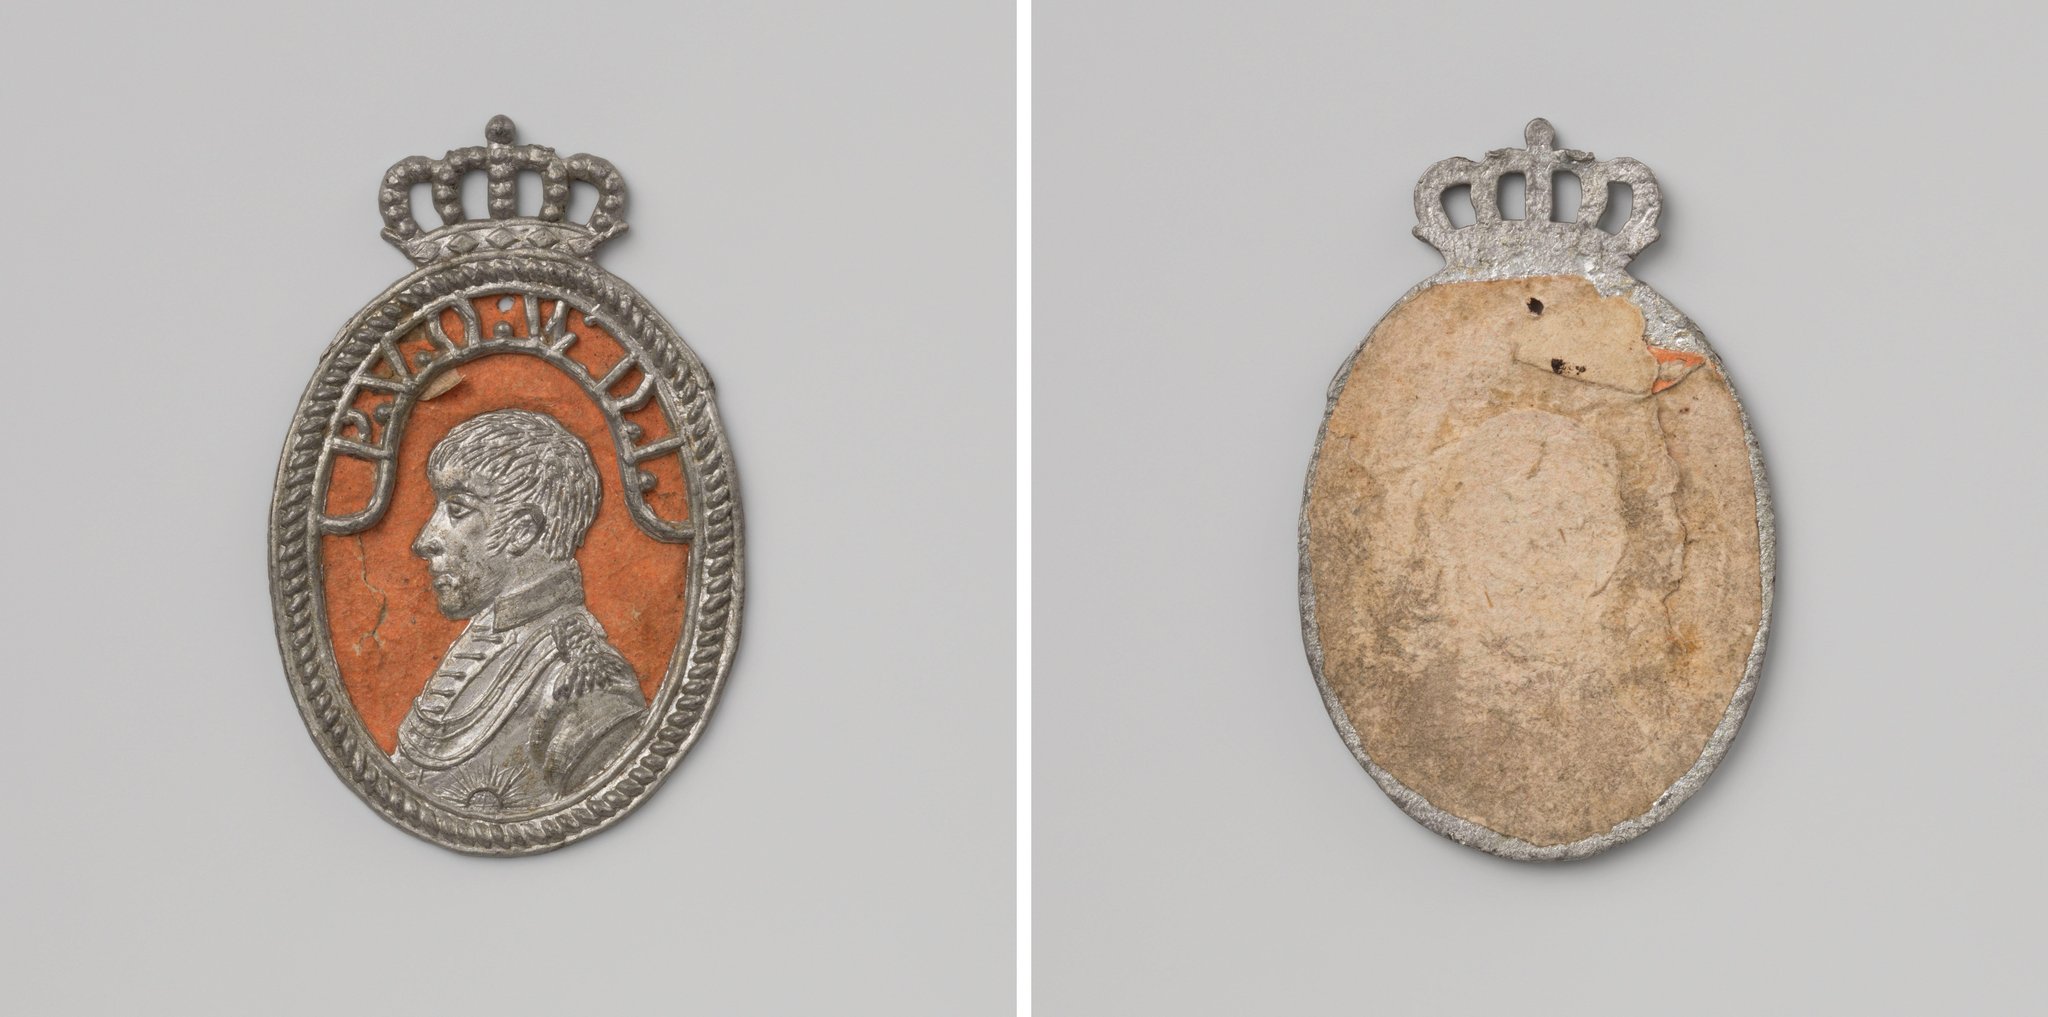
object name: insignia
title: Willem Frederik, prins van Oranje-Nassau, souverein vorst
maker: Anonymous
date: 1813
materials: cardboard, silver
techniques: embroidery, striking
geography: netherlands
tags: the hague, berlin, william i of the netherlands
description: Eenzijdig zilveren ovaal opengewerkt draagteken, met kabelrand onder kroon, beplakt met oranje karton. Voorzijde: borststuk man binnen omschrift. Keerzijde: blanco